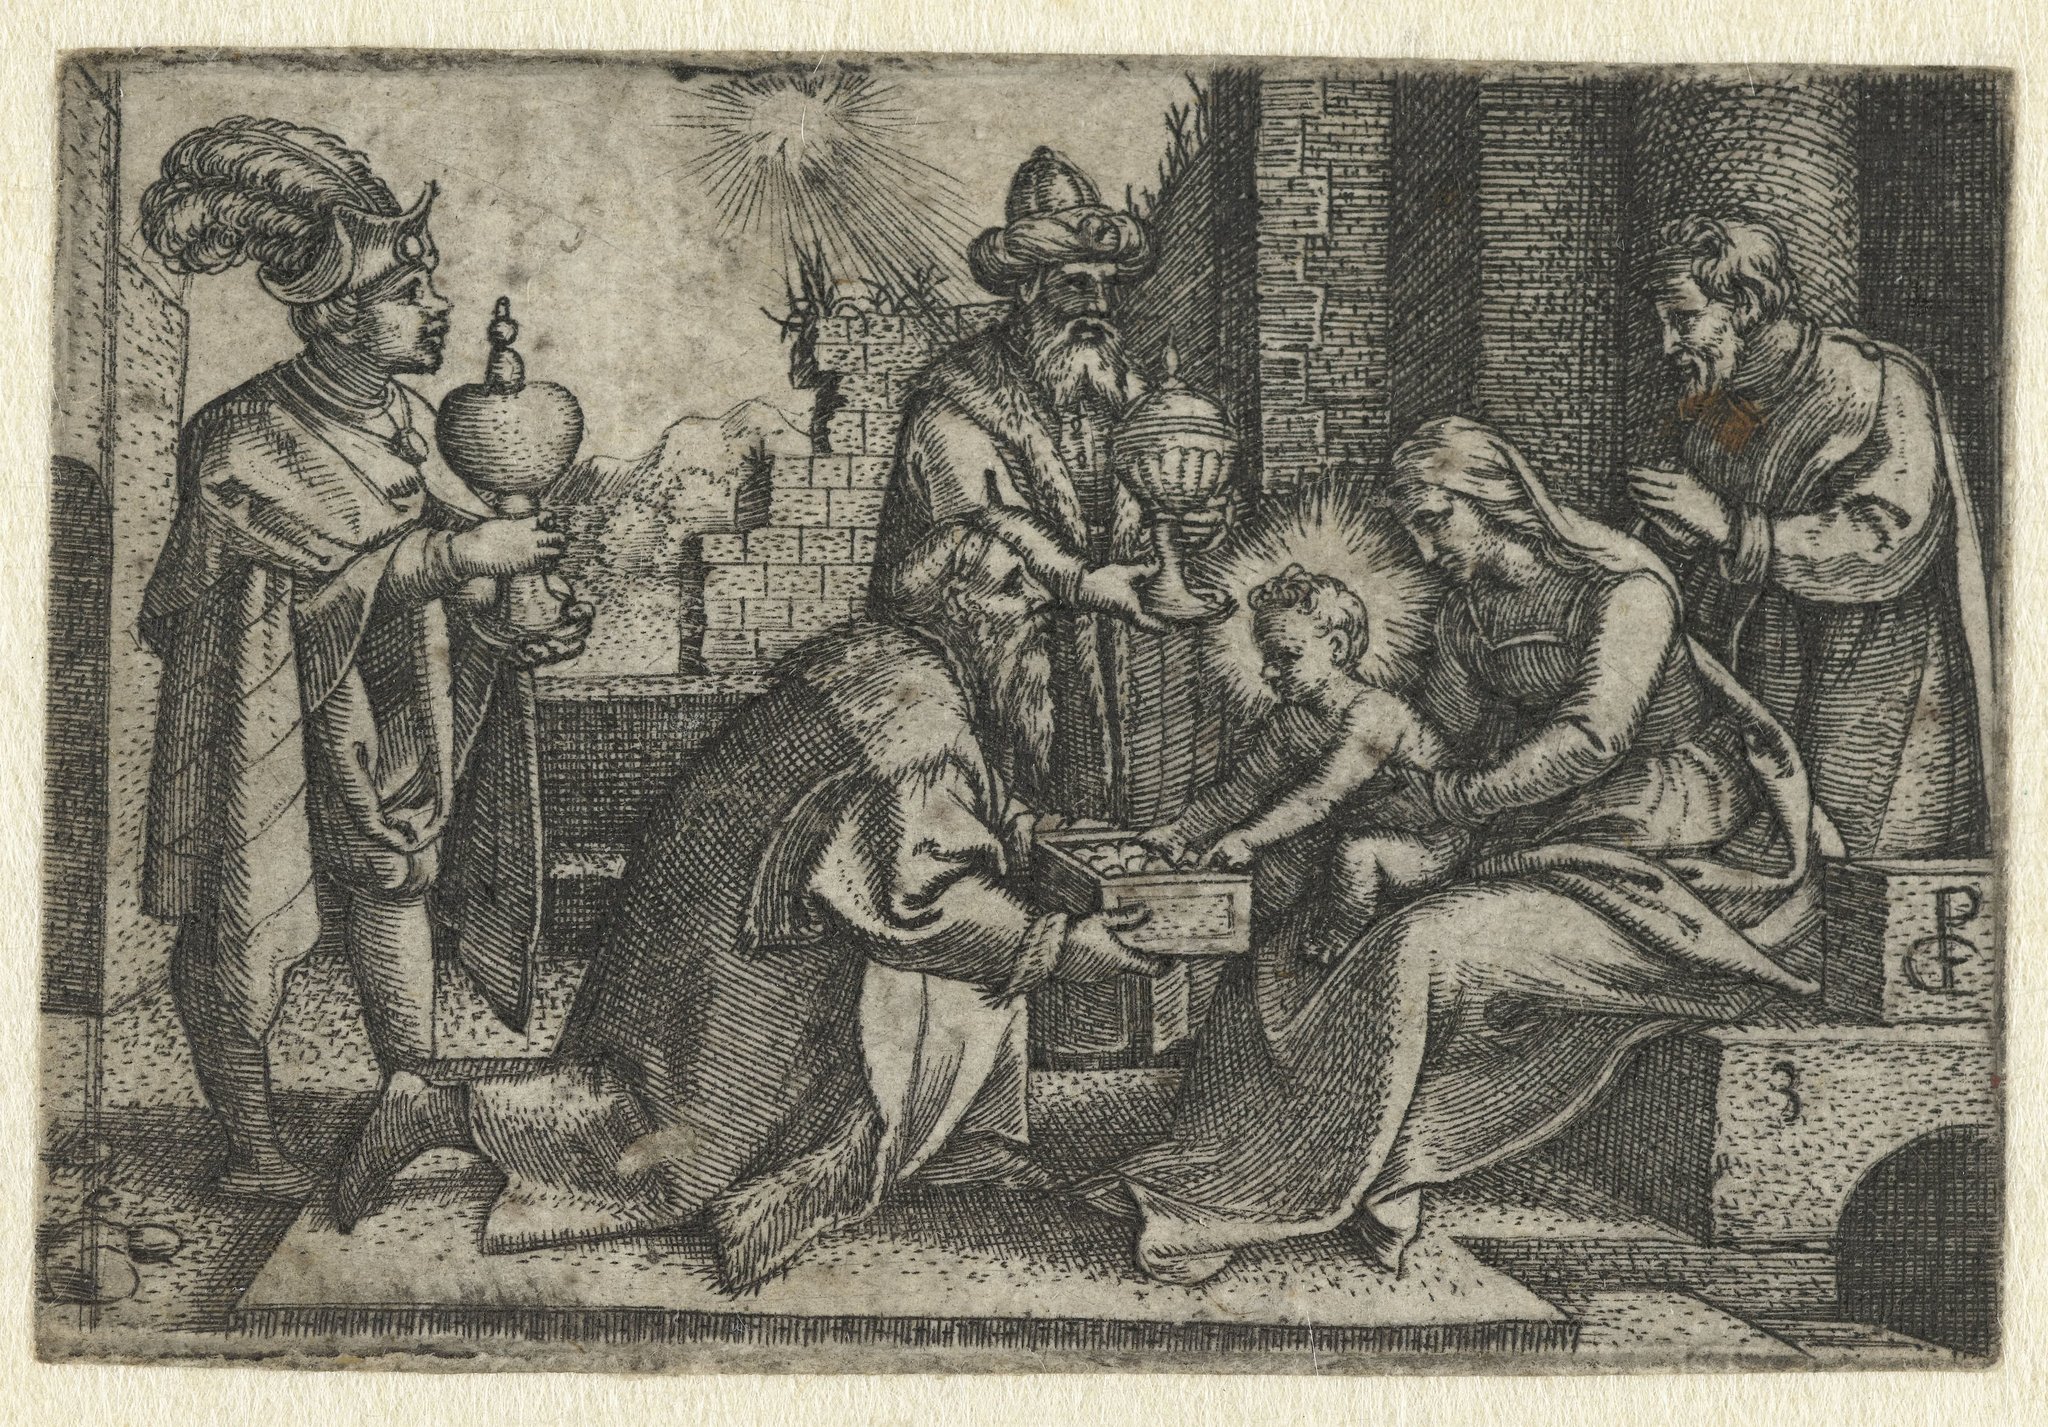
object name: print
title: Leven van Christus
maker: georg pencz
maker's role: draughtsman, painter, print maker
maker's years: 1500-1550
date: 1534-1535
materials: paper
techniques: engraving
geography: germany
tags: adoration of the kings: the wise men present their gifts to the christ-child (gold, frankincense and myrrh)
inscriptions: collector's mark: ‘Hinloopen’ Lugt 11